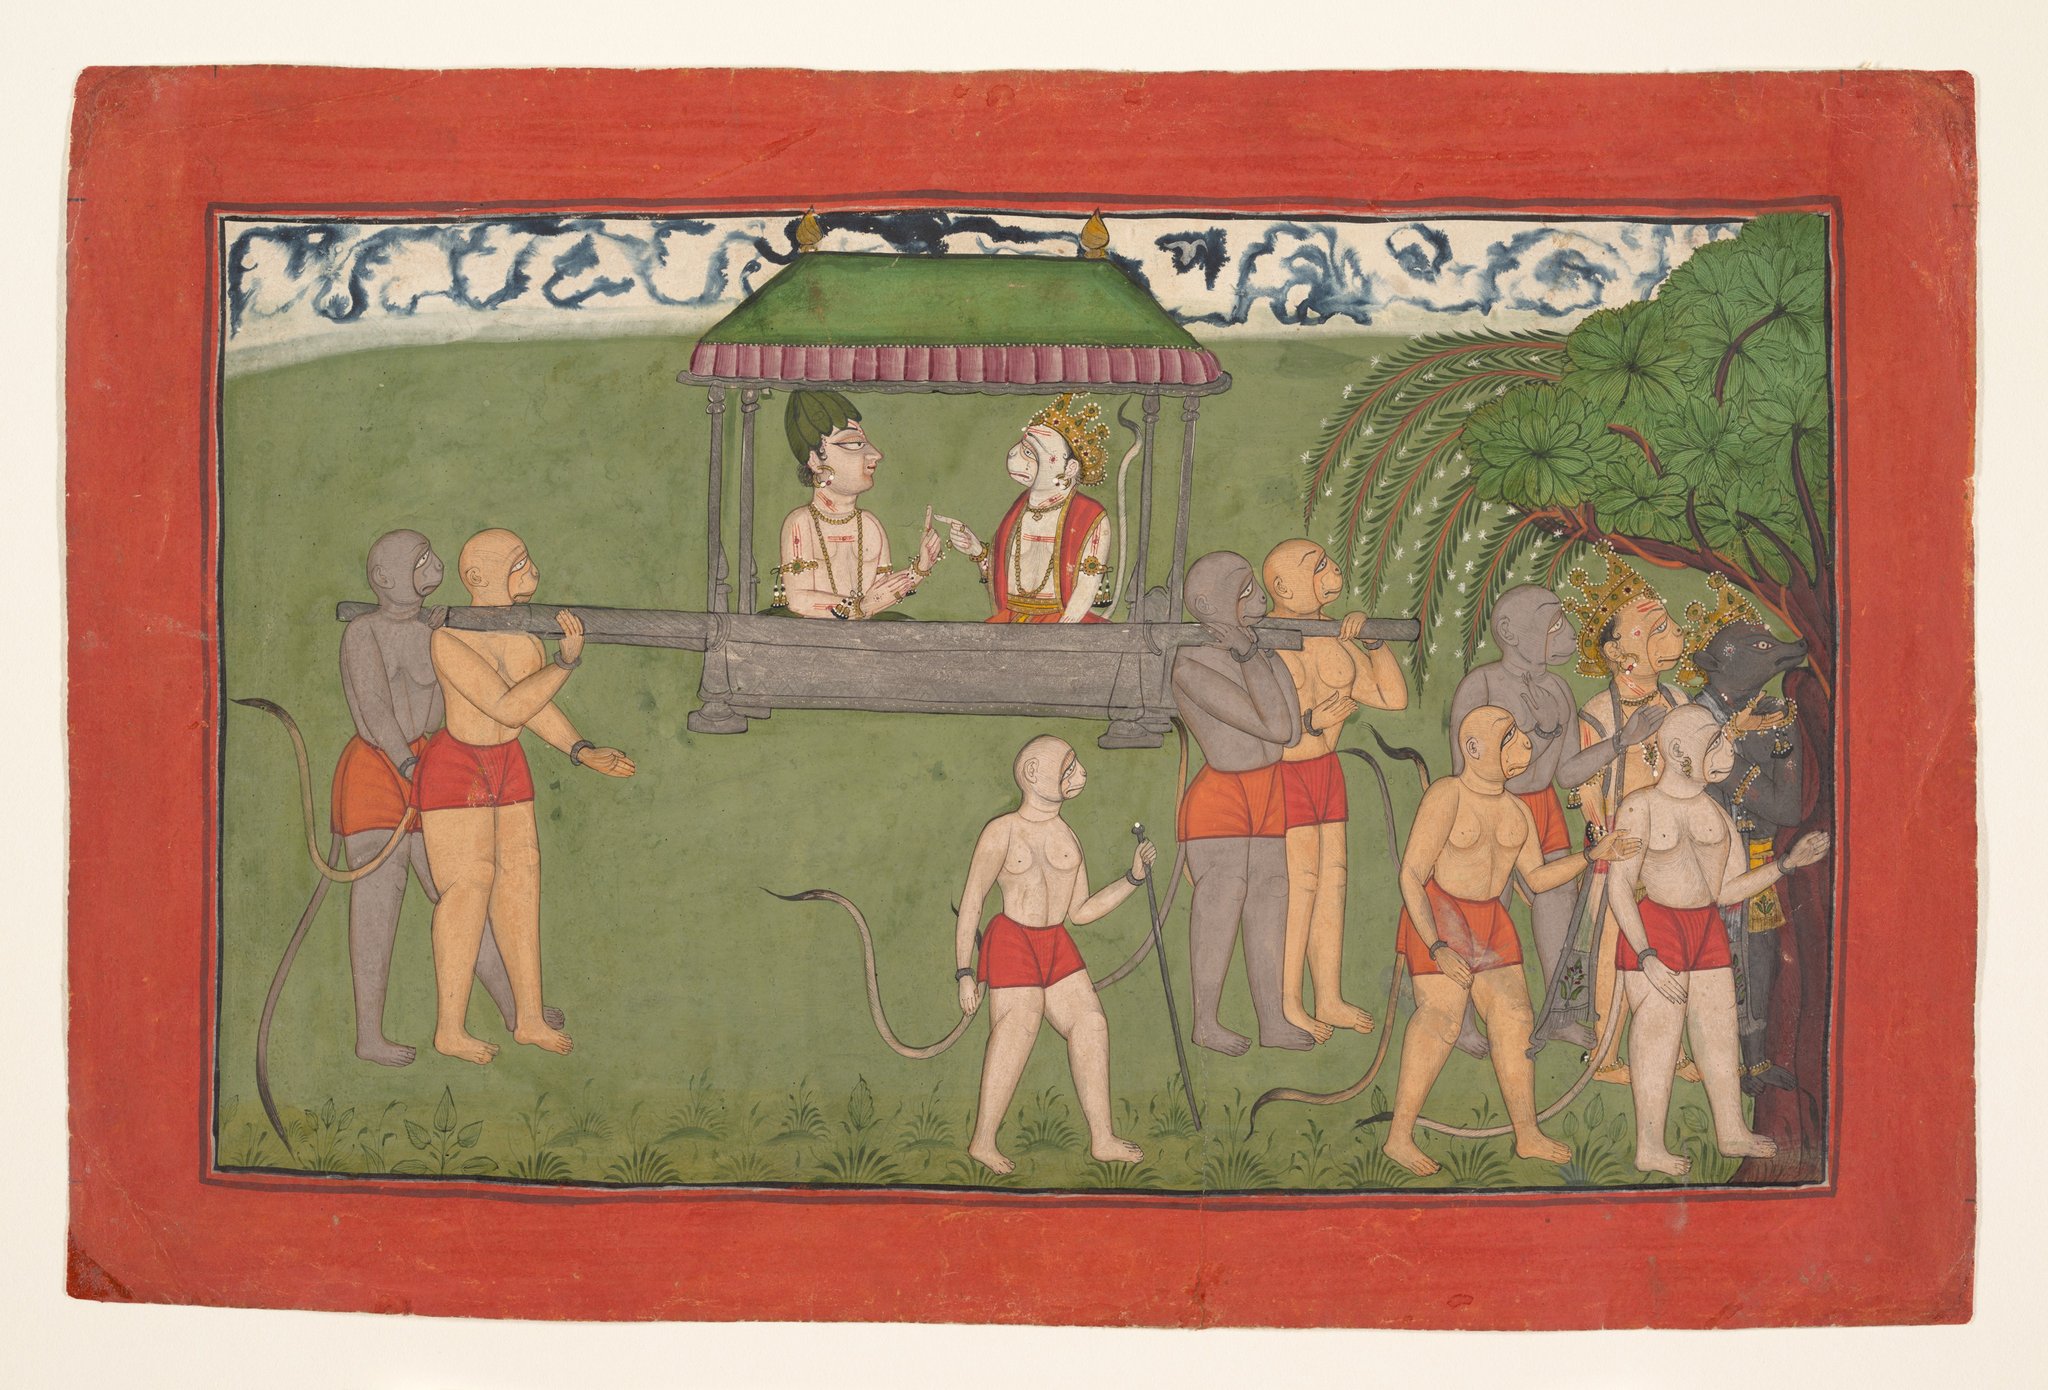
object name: folio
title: Lakshmana and Sugriva Being Carried by Palanquin to Receive Rama's Blessings: Folio from the dispersed “Mankot" Ramayana series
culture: indian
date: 1710-1725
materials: ink, paper, watercolor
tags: bears,men,monkeys